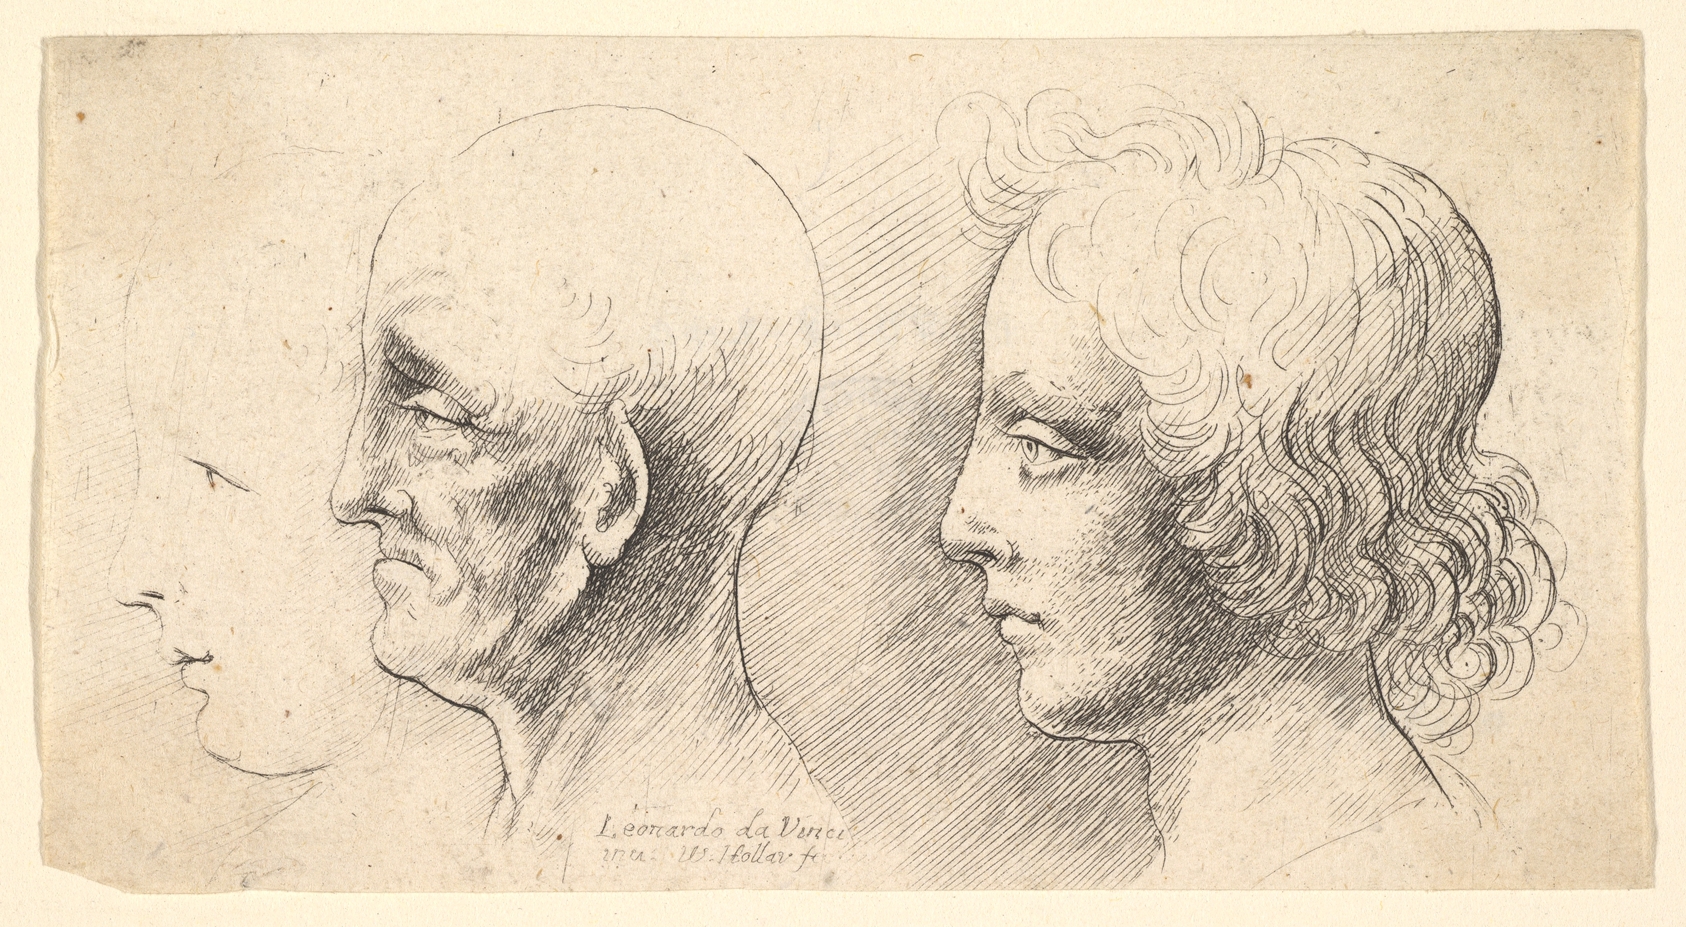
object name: print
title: Three profile heads, one in outline only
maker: wenceslaus hollar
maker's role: artist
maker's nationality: bohemian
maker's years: 1607-1677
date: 1644-1652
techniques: etching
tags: men